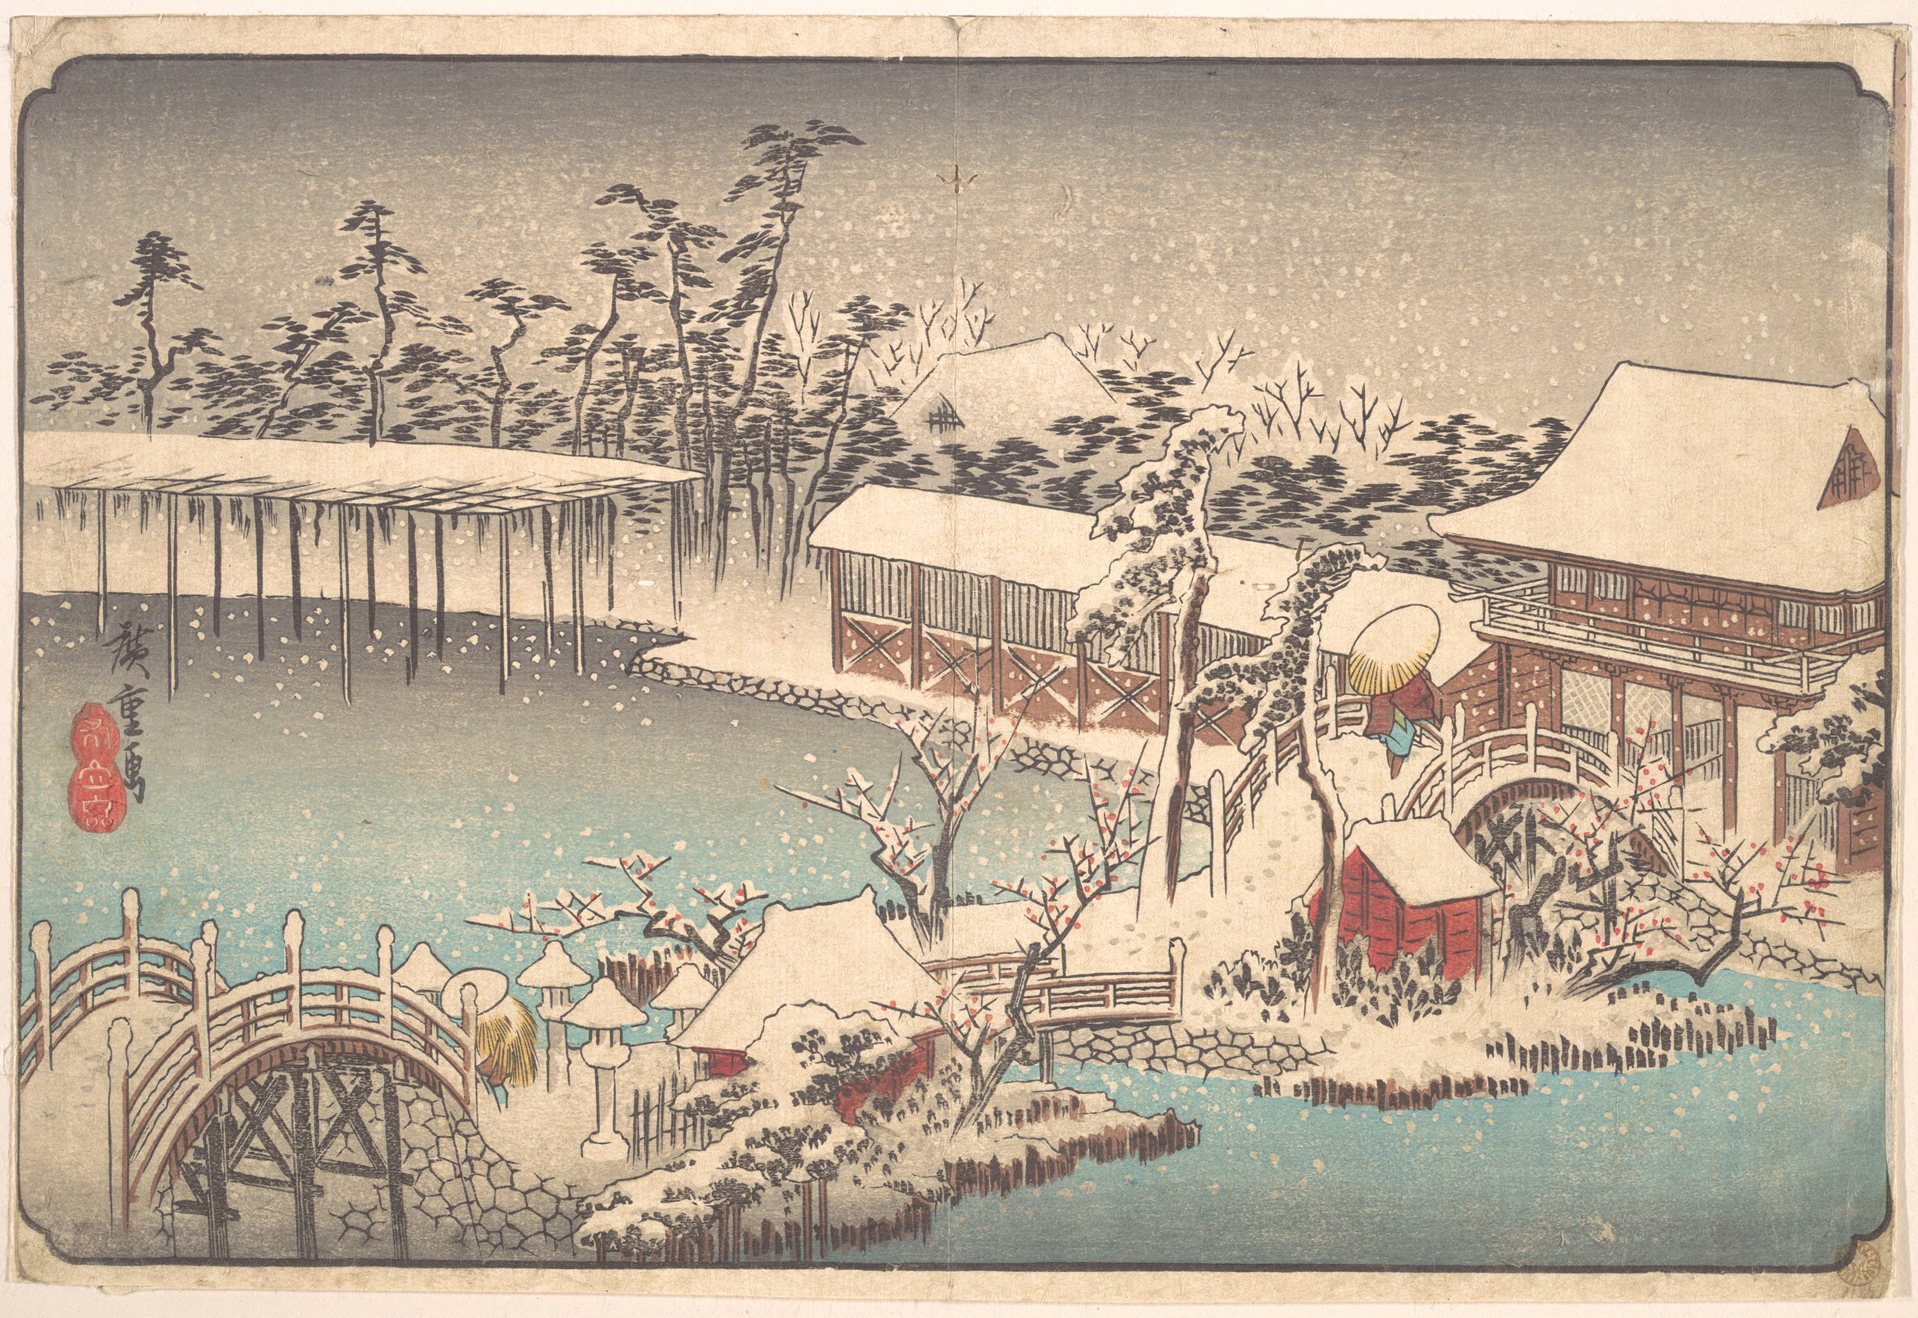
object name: print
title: Kameido Tenmangu Keidai no Yuki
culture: japanese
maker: utagawa hiroshige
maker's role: artist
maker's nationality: japanese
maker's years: 1797-1858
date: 1833-1834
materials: ink, paper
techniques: woodblock print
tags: houses,bridges,trees,snow